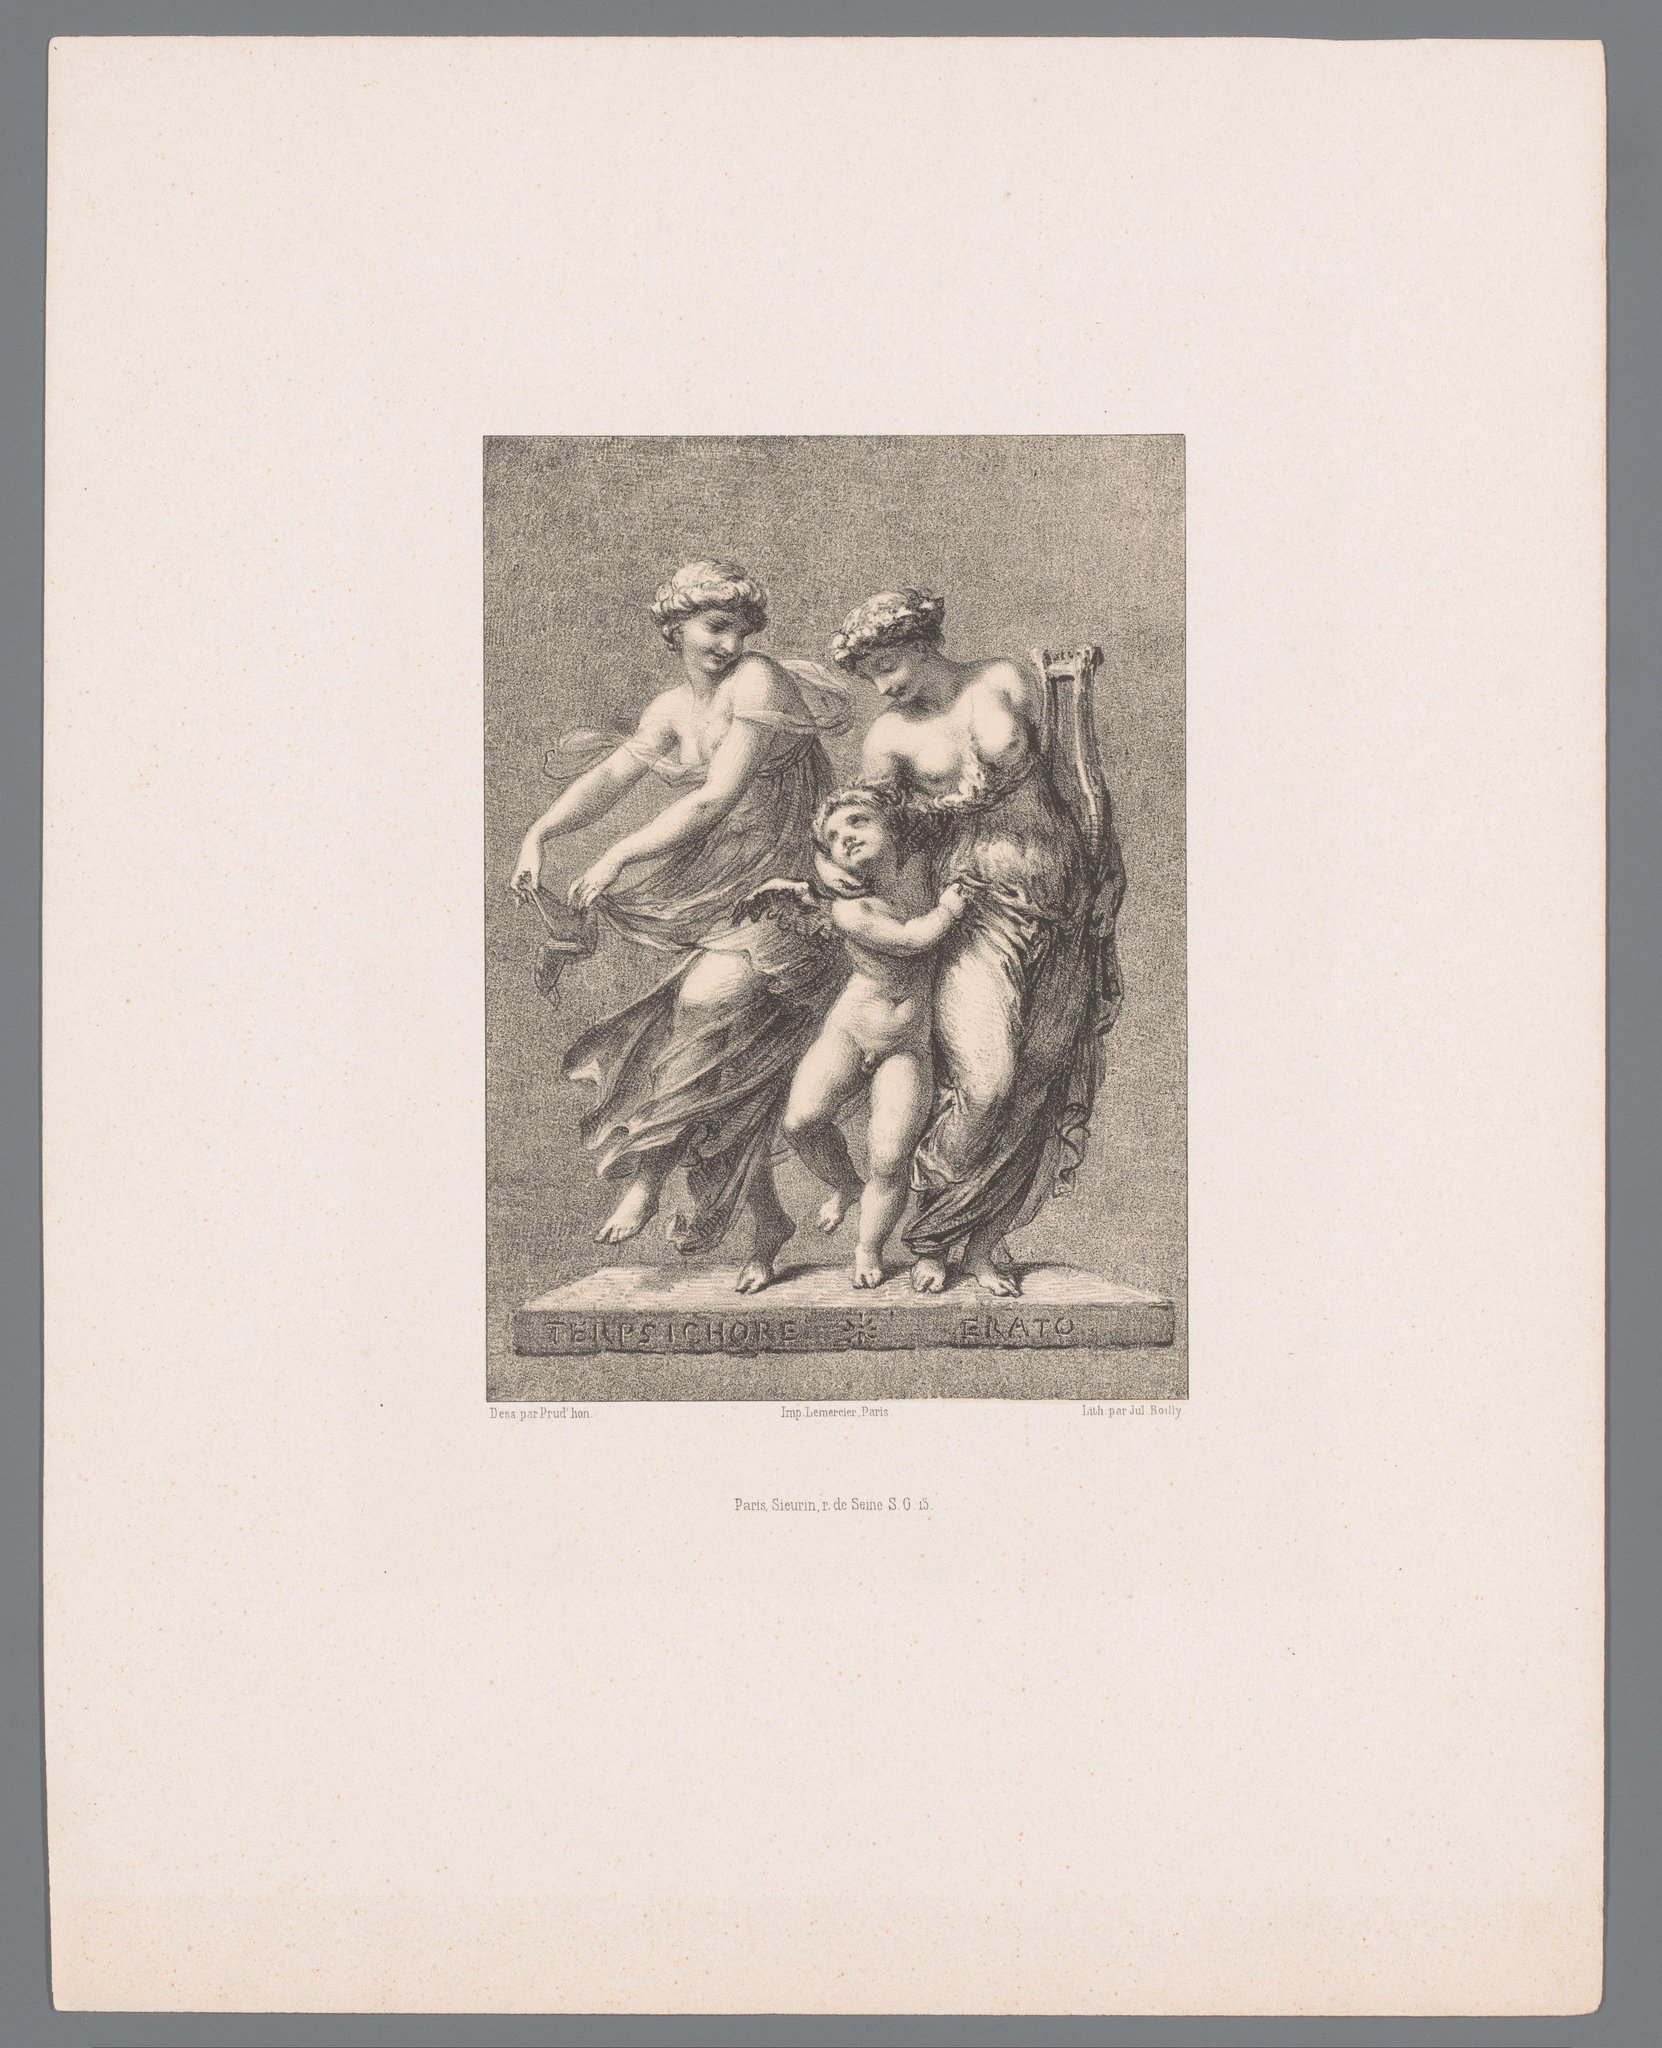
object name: print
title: Apollon et les Muses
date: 1851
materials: paper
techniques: lithograph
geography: paris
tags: erato (one of the muses); 'erato' (ripa), terpsichore (one of the muses); 'terpsicore' (ripa)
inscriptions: collector's mark: Lugt 2228a, collector's mark: Lugt 2760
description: Deze prent maakt deel uit van een omslag met zeven prenten.